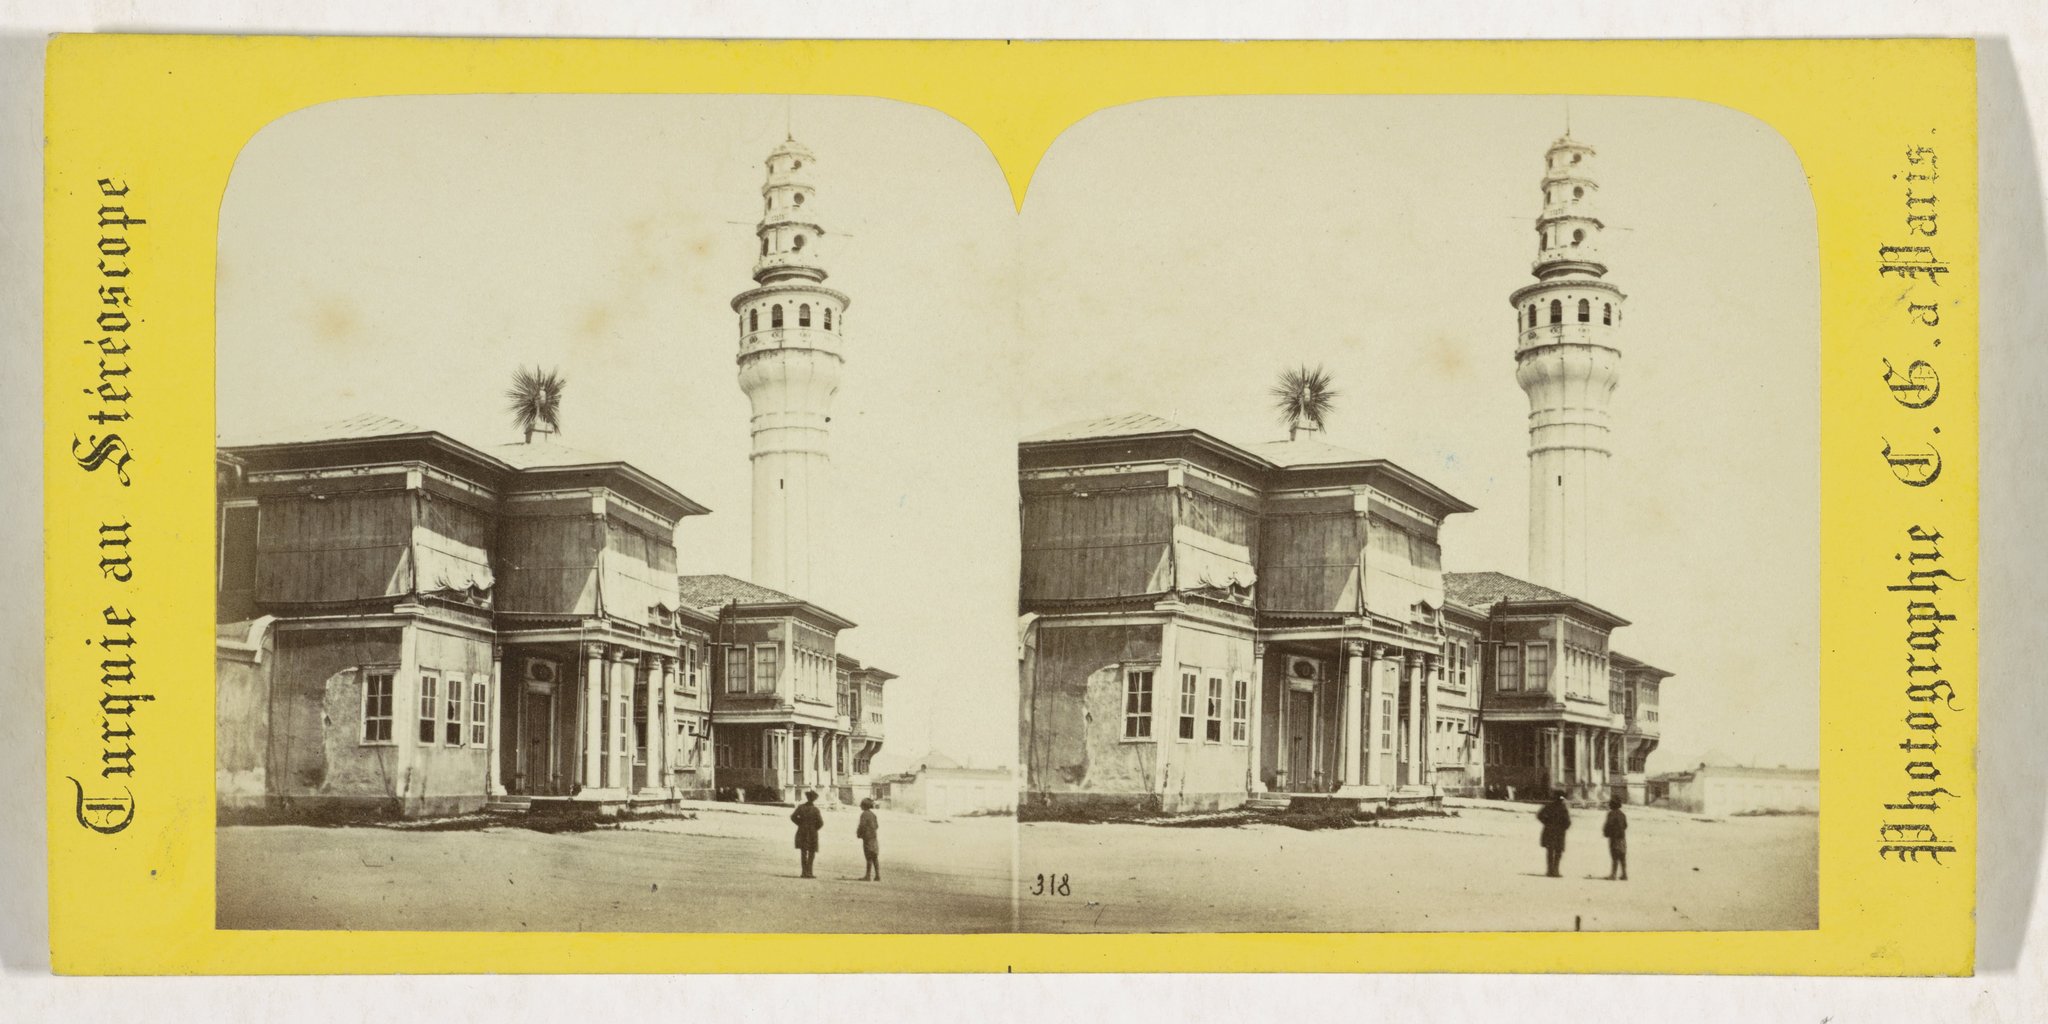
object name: stereograph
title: Beyazit-toren in Istanboel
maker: charles gaudin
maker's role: publisher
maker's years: 1825-1905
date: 1861-1870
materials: cardboard, paper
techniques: albumen print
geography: beyazıt tower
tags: tower (of house or building)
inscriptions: number: ‘318’